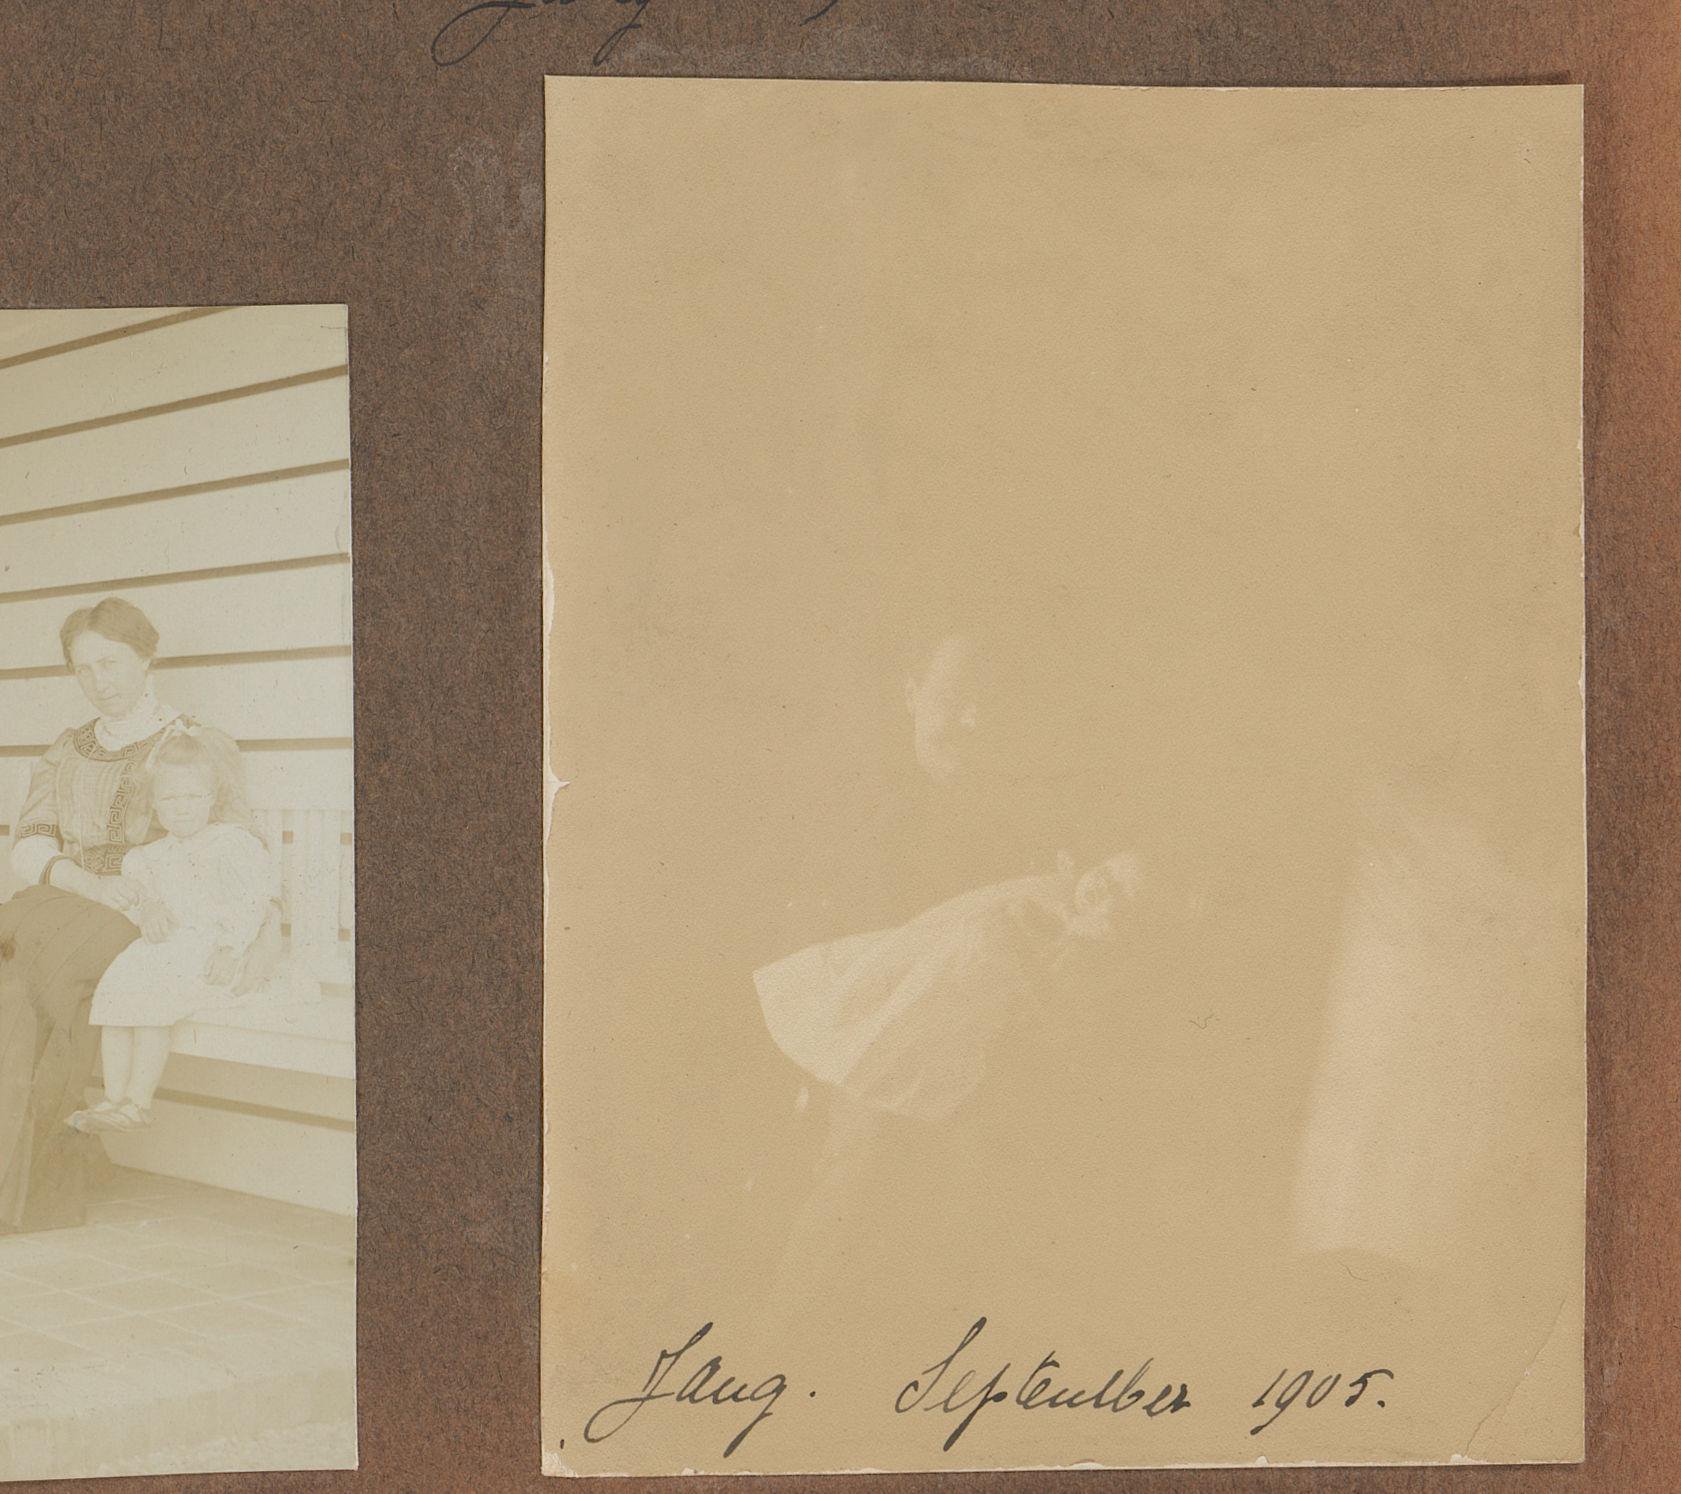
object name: photograph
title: Alphons Diepenbrock met dochter Joanna op schoot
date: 1905-1909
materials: photographic support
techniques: photography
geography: netherlands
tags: amsterdam, alphons diepenbrock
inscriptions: date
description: Foto op bruin albumblad 3 van familiealbum van Alphons Diepenbrock.